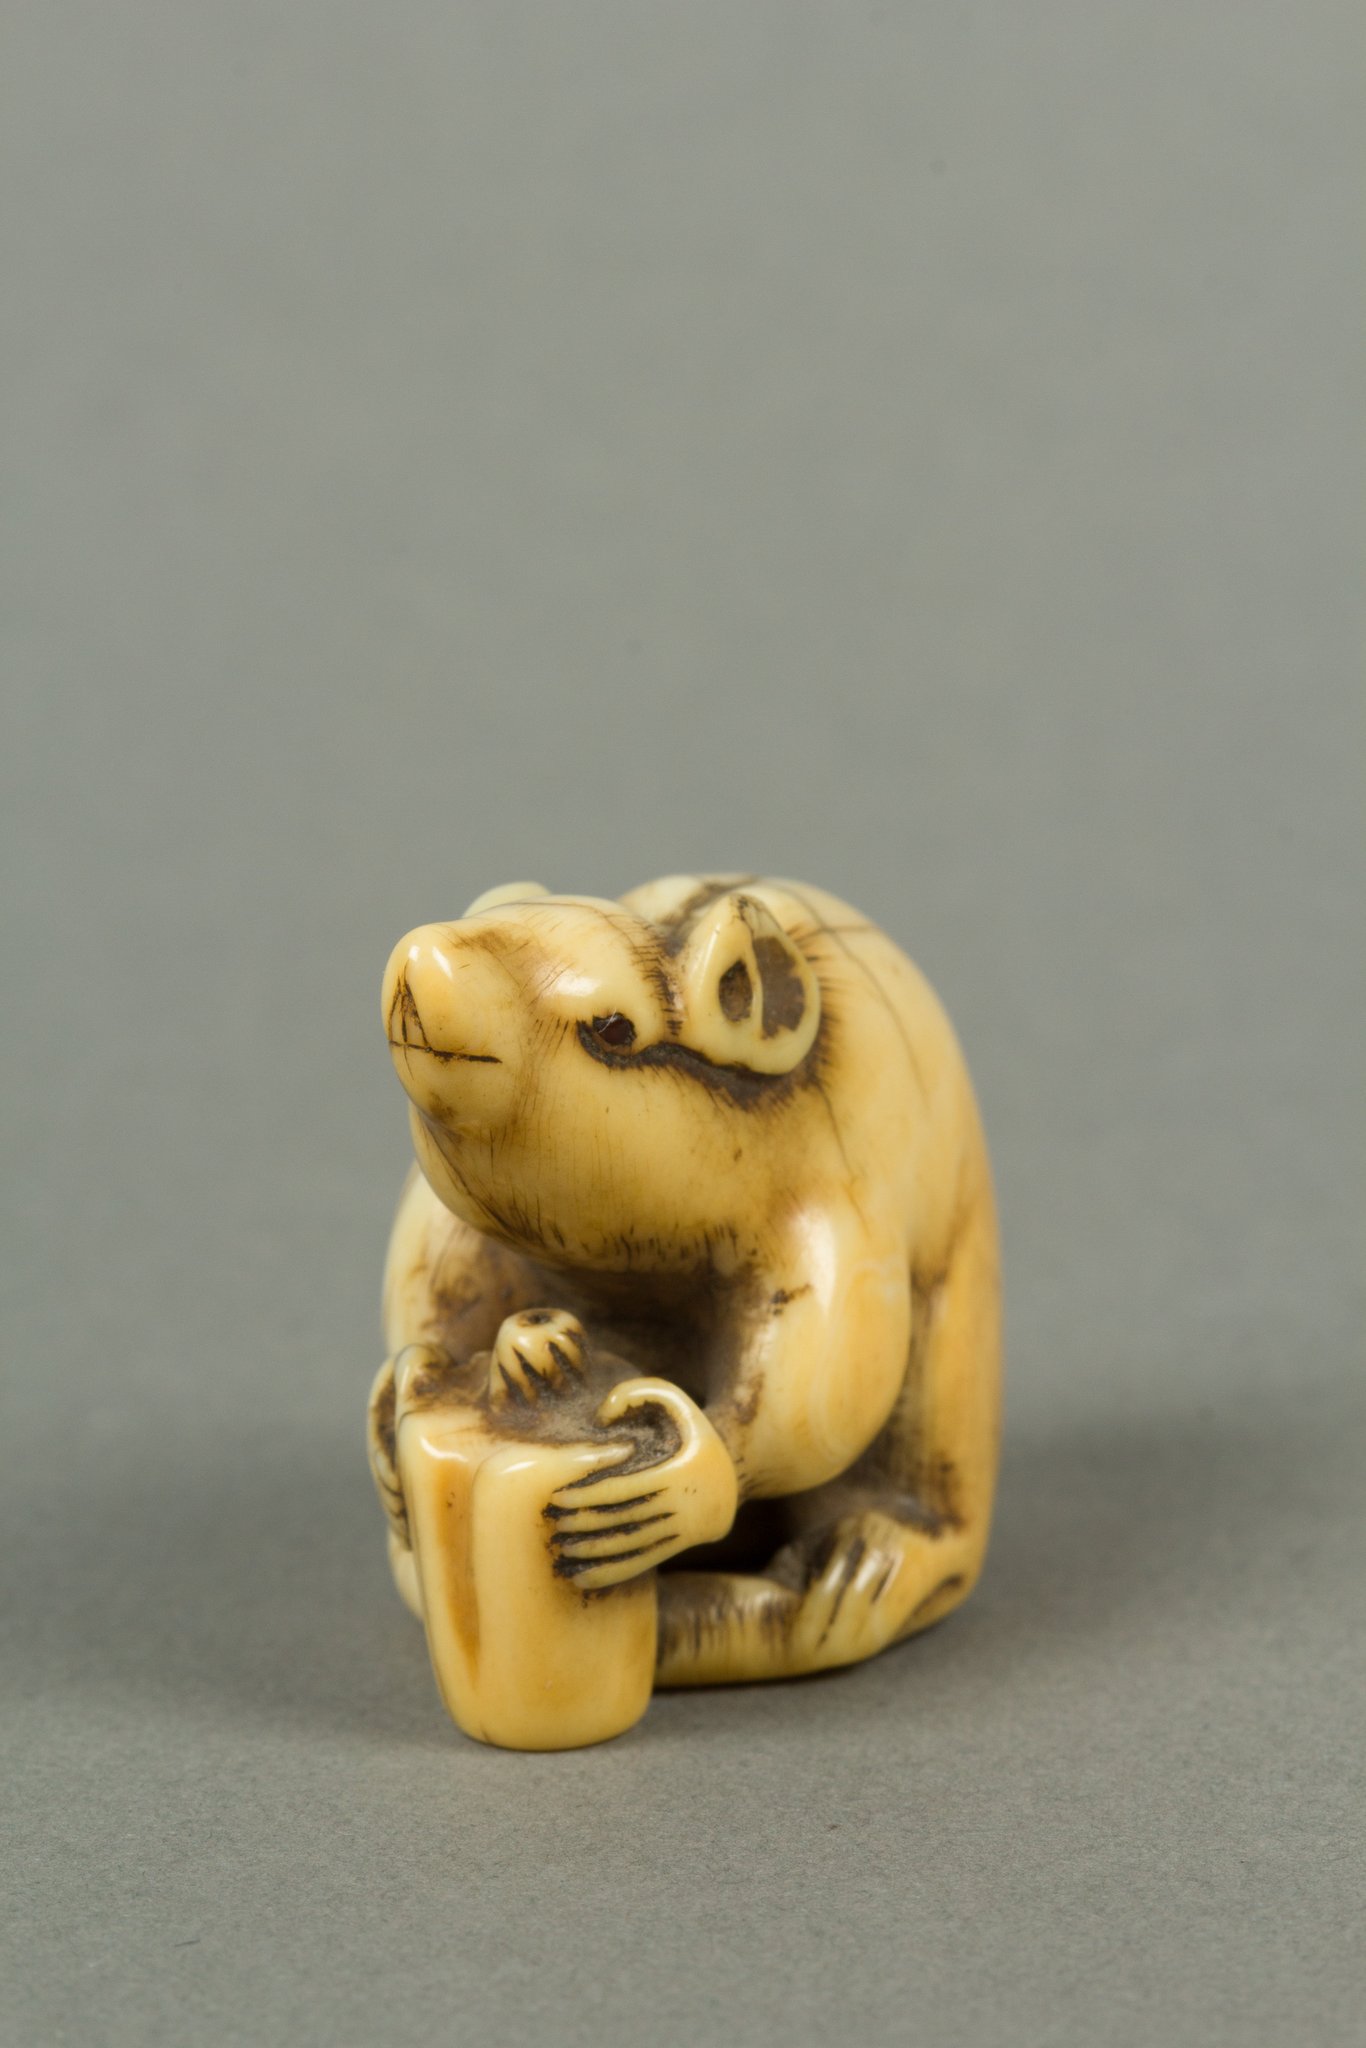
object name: netsuke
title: Netsuke of Mouse Gnawing on Candle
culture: japanese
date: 1701-1800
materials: ivory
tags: mice